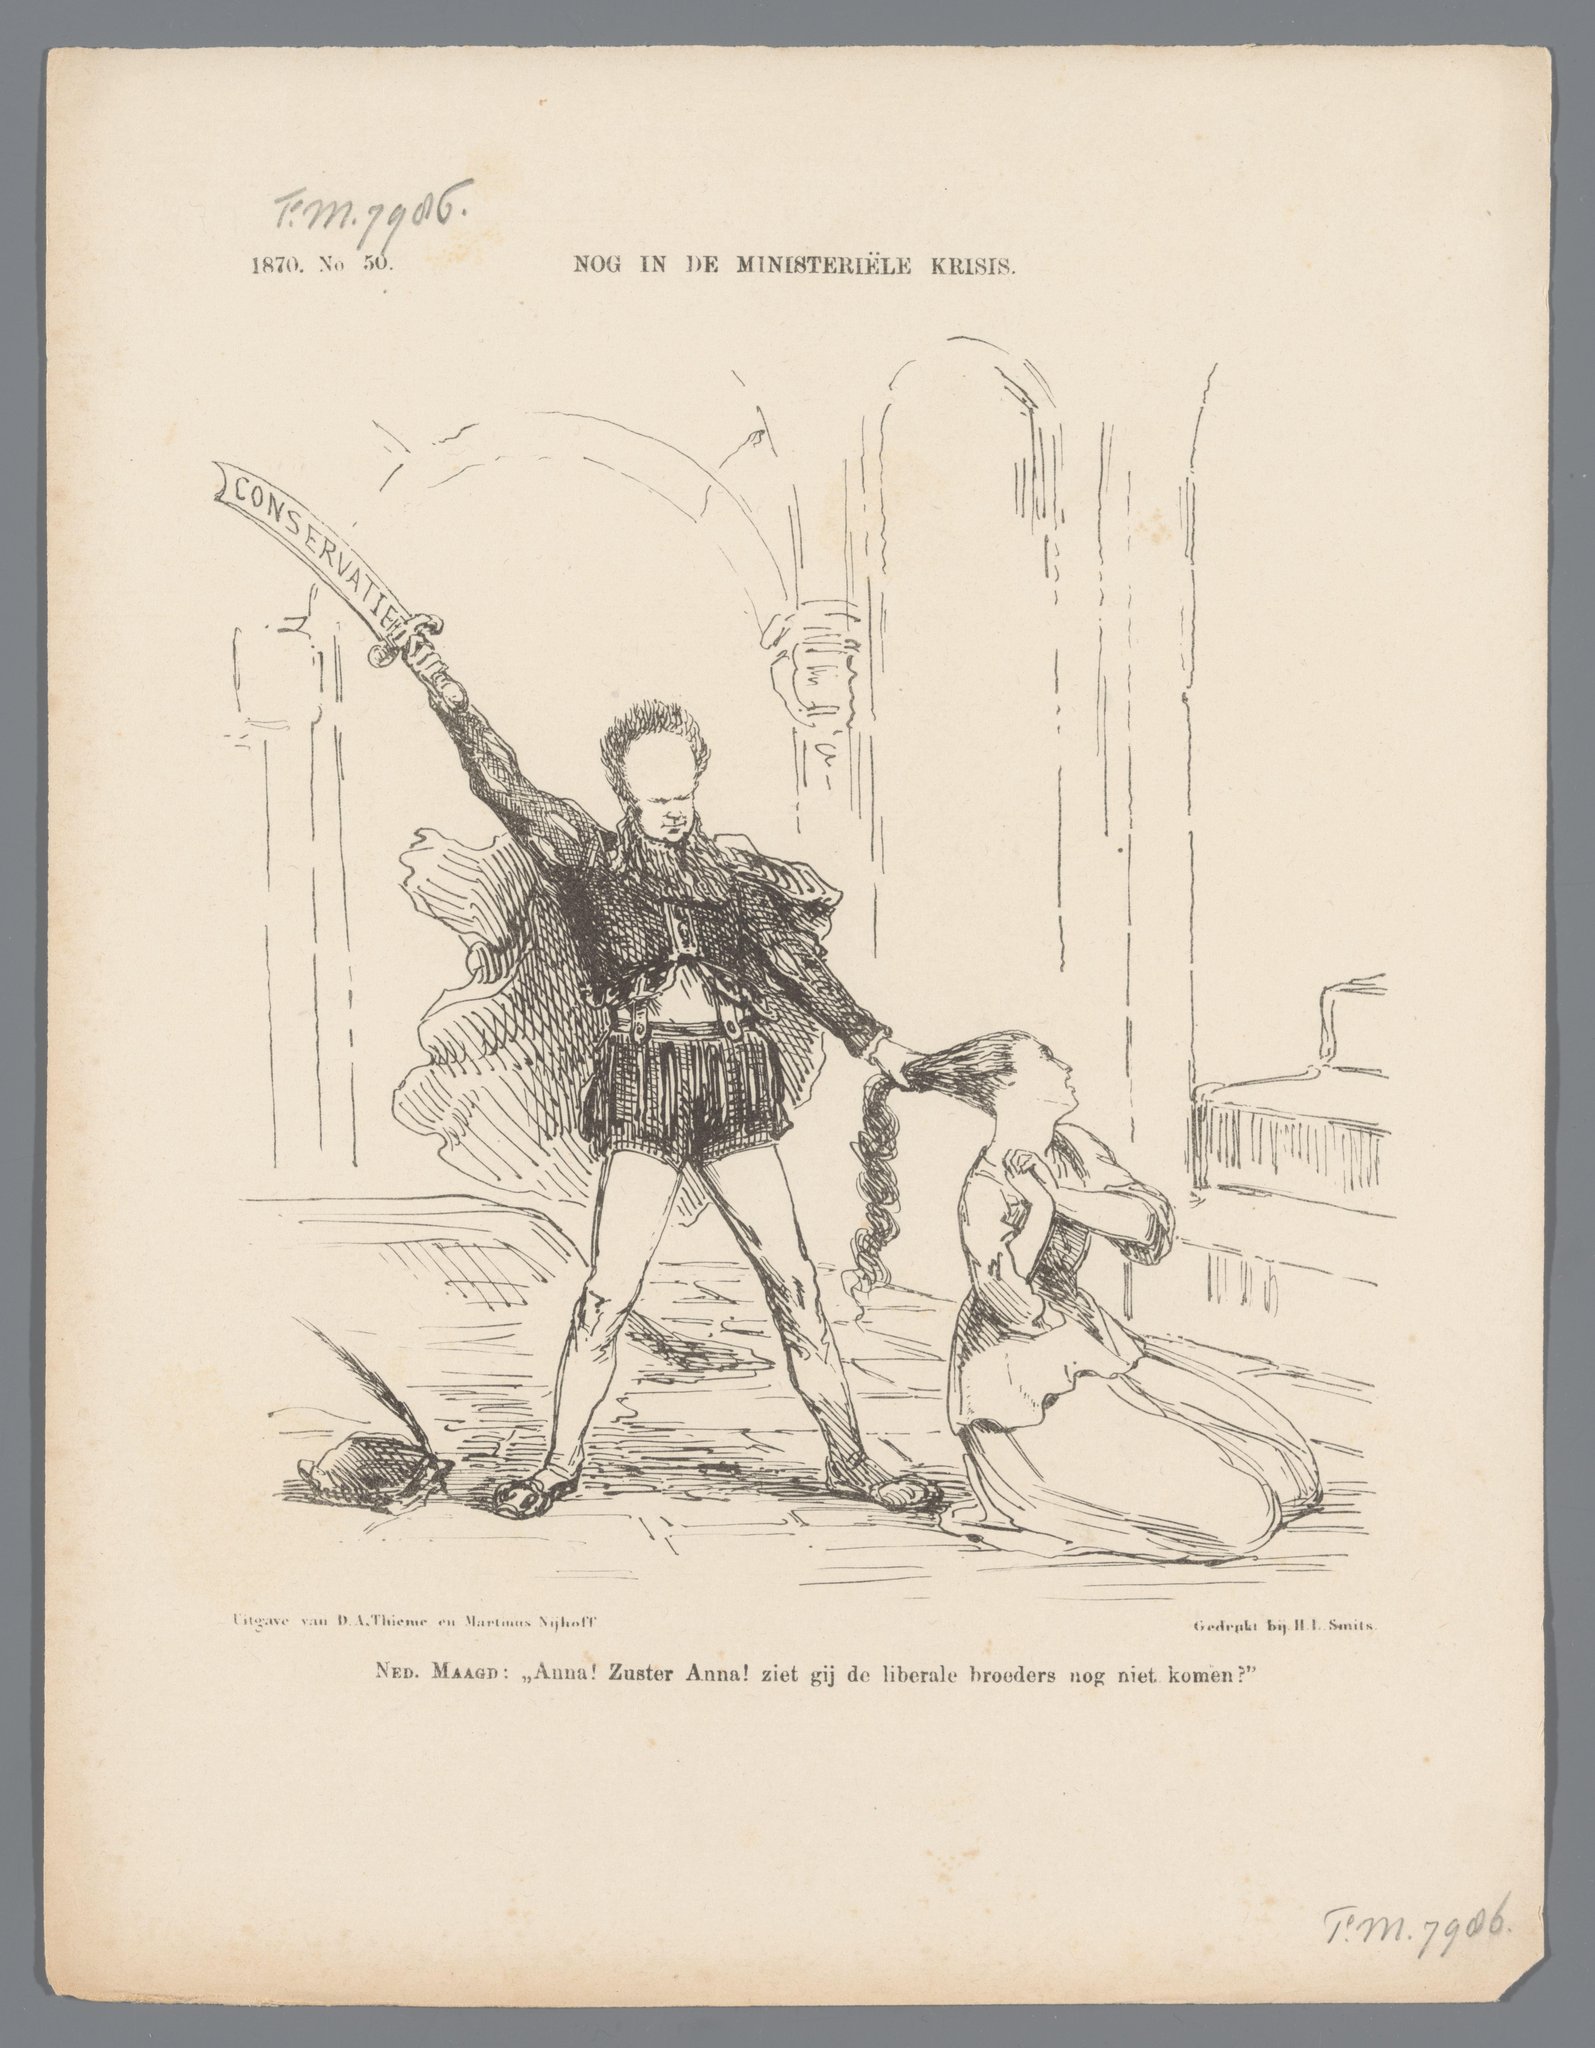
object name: print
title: Spotprent op de ministeriële krisis, 1870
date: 1870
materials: paper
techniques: lithograph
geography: arnhem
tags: personifications of countries, nations, states, districts, etc., tales and fairy tales (with title)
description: Spotprent op de langdurige ministeriële krisis. Blauwbaard (Heemskerk) dreigt zijn vrouw (Nederlandse Maagd) met het zwaard het hoofd af te slaan. Zij roept 'Anna! Zuster Anna! ziet gij ... nog niet komen?' Plaat verschenen bij het weekblad De Nederlandsche Spectator, nr. 50, 1870.